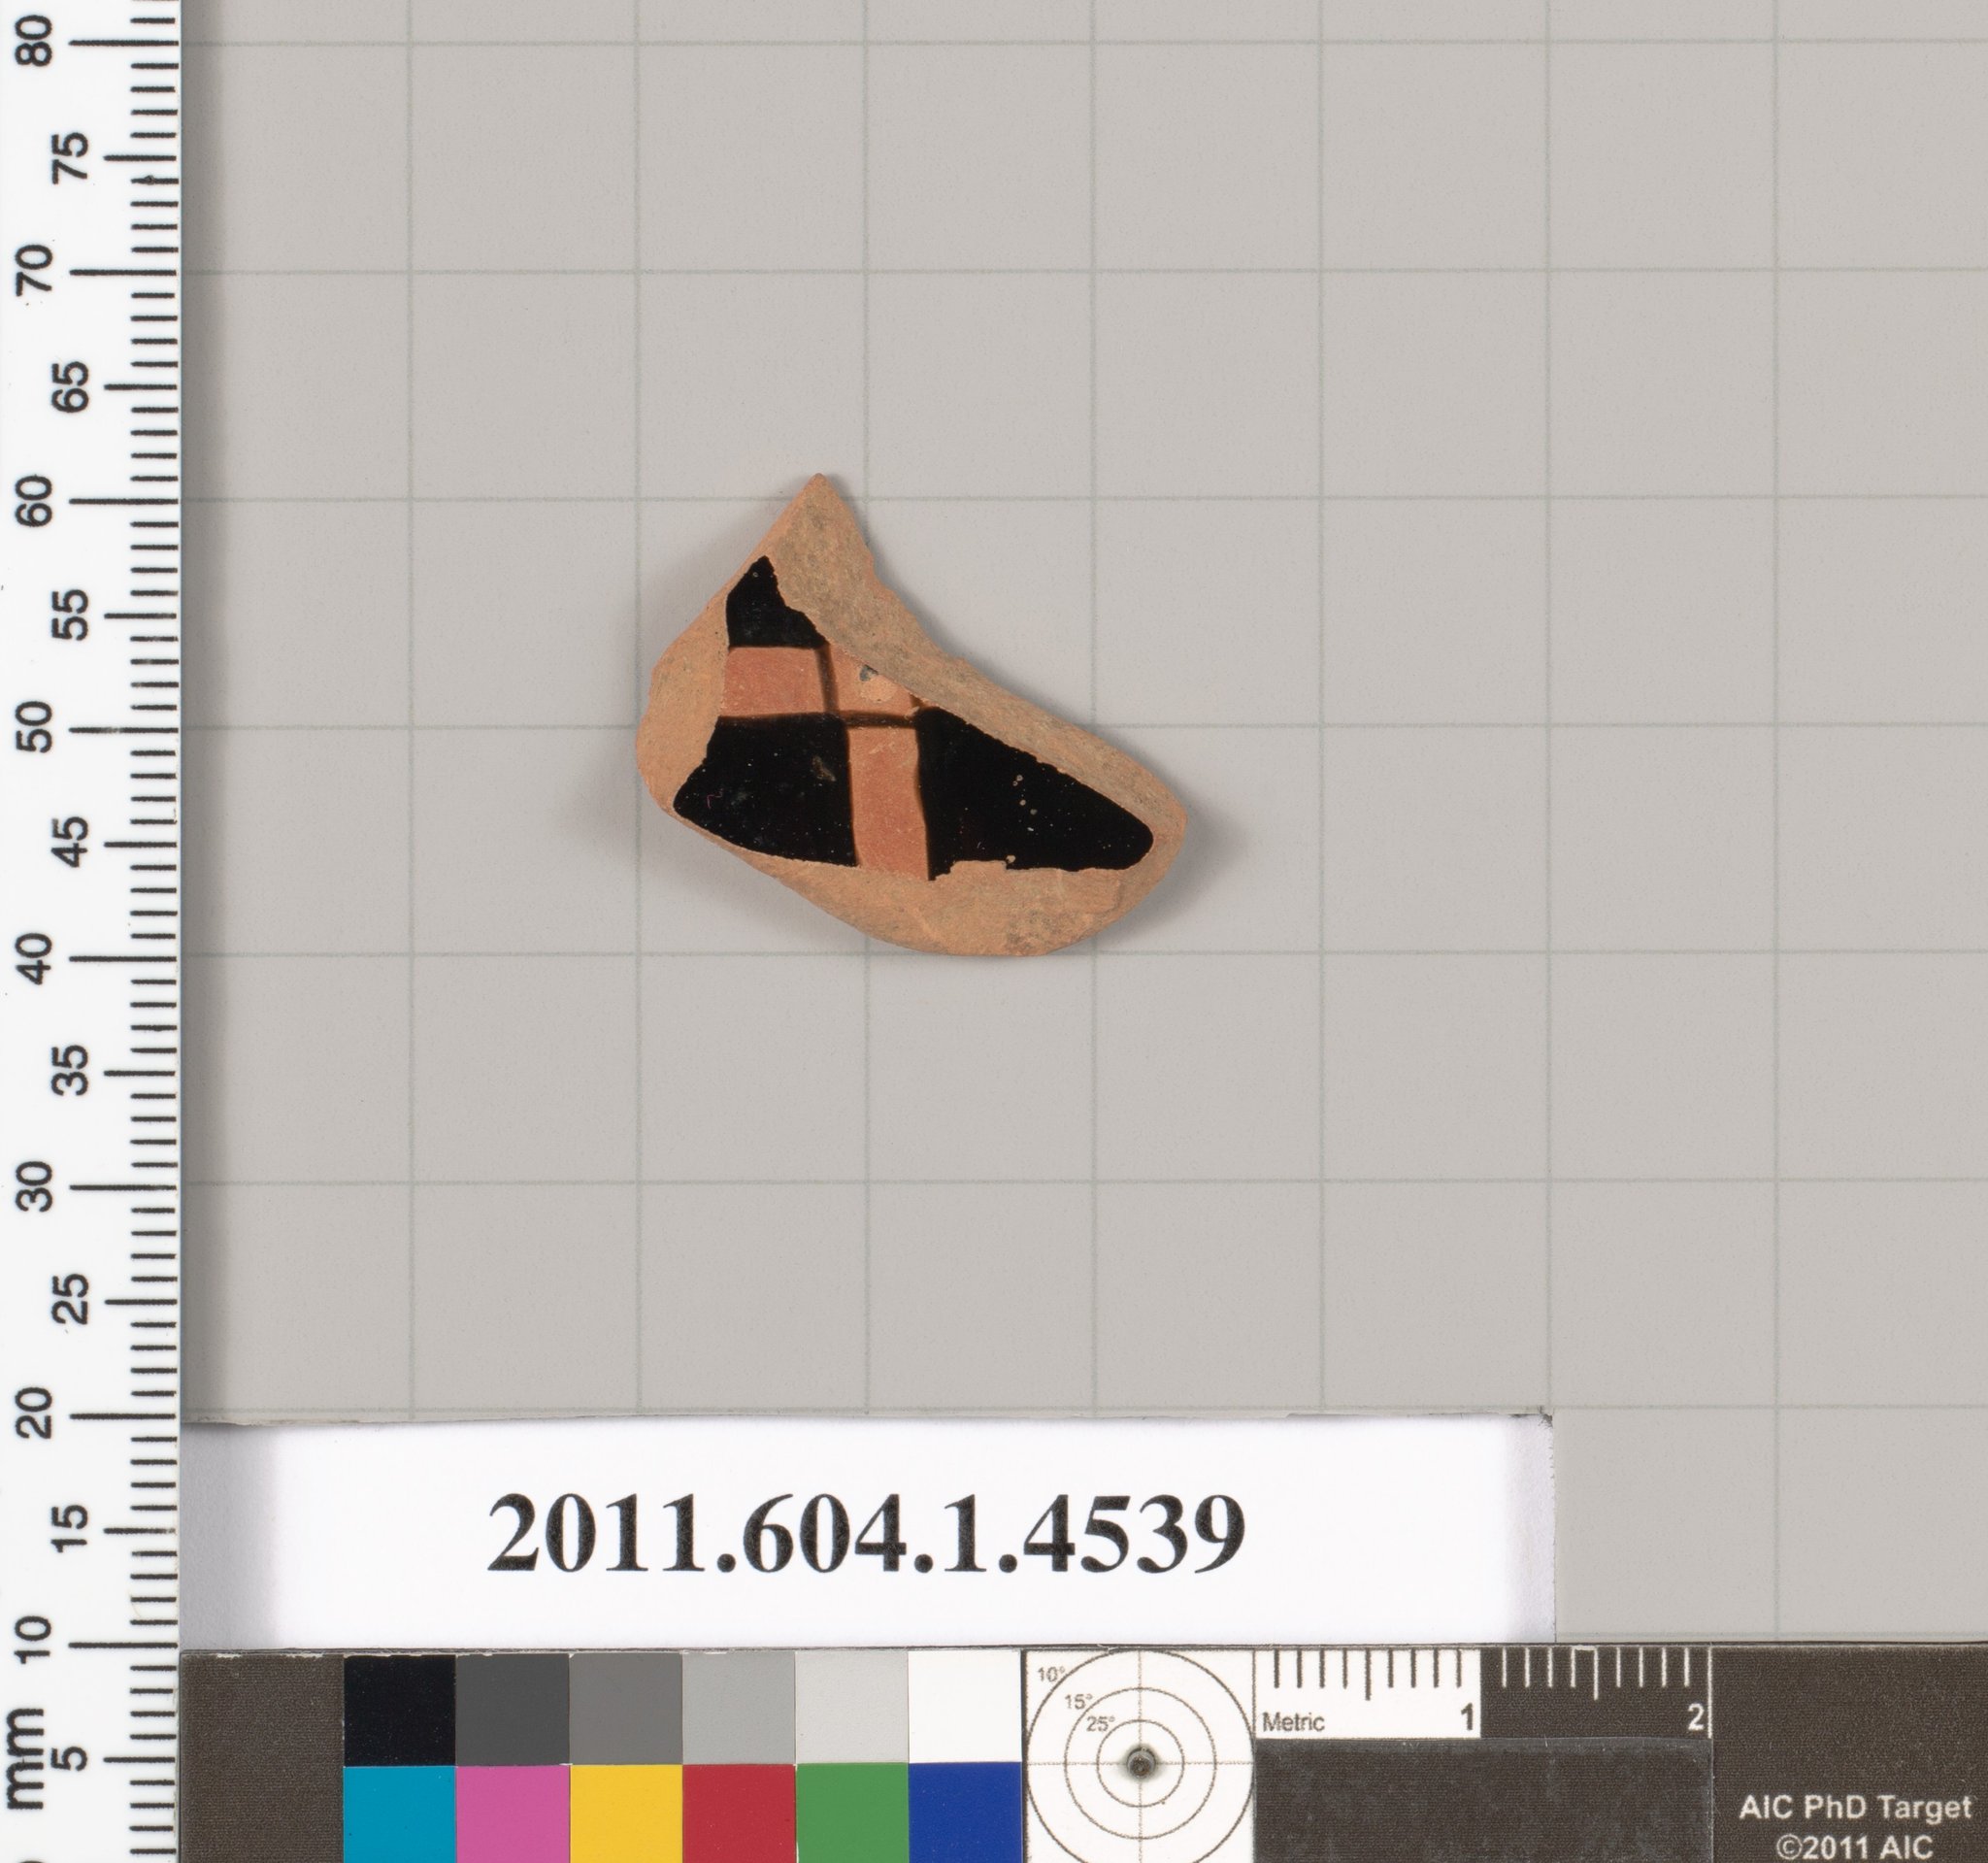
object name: kylix fragment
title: Terracotta fragment of a kylix (drinking cup)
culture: greek, attic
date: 475-451 BCE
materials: terracotta